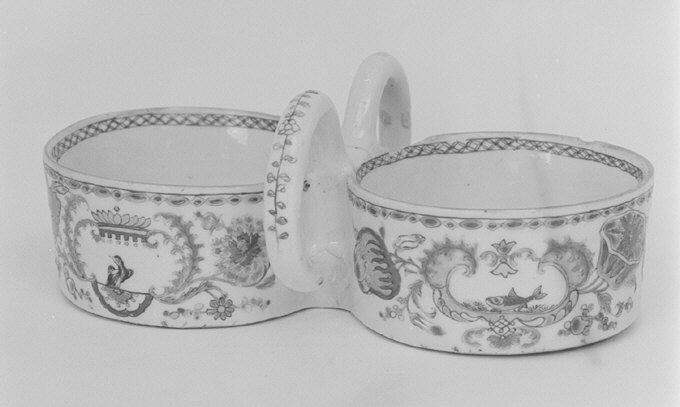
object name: cruet stand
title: Cruet stand (part of a set)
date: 1725-1740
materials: hard paste porcelain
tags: birds,fish,flowers